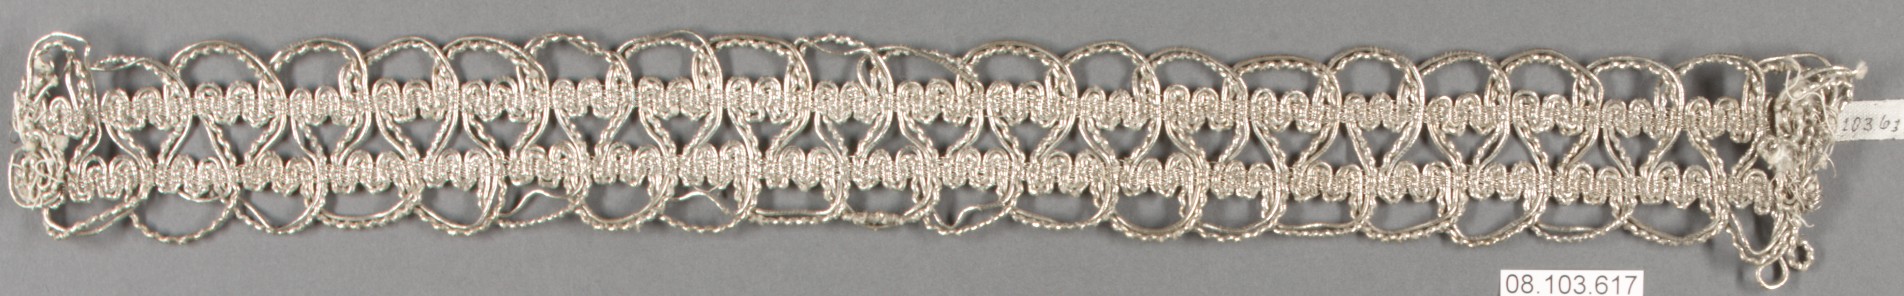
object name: galloon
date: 1601-1700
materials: metal thread